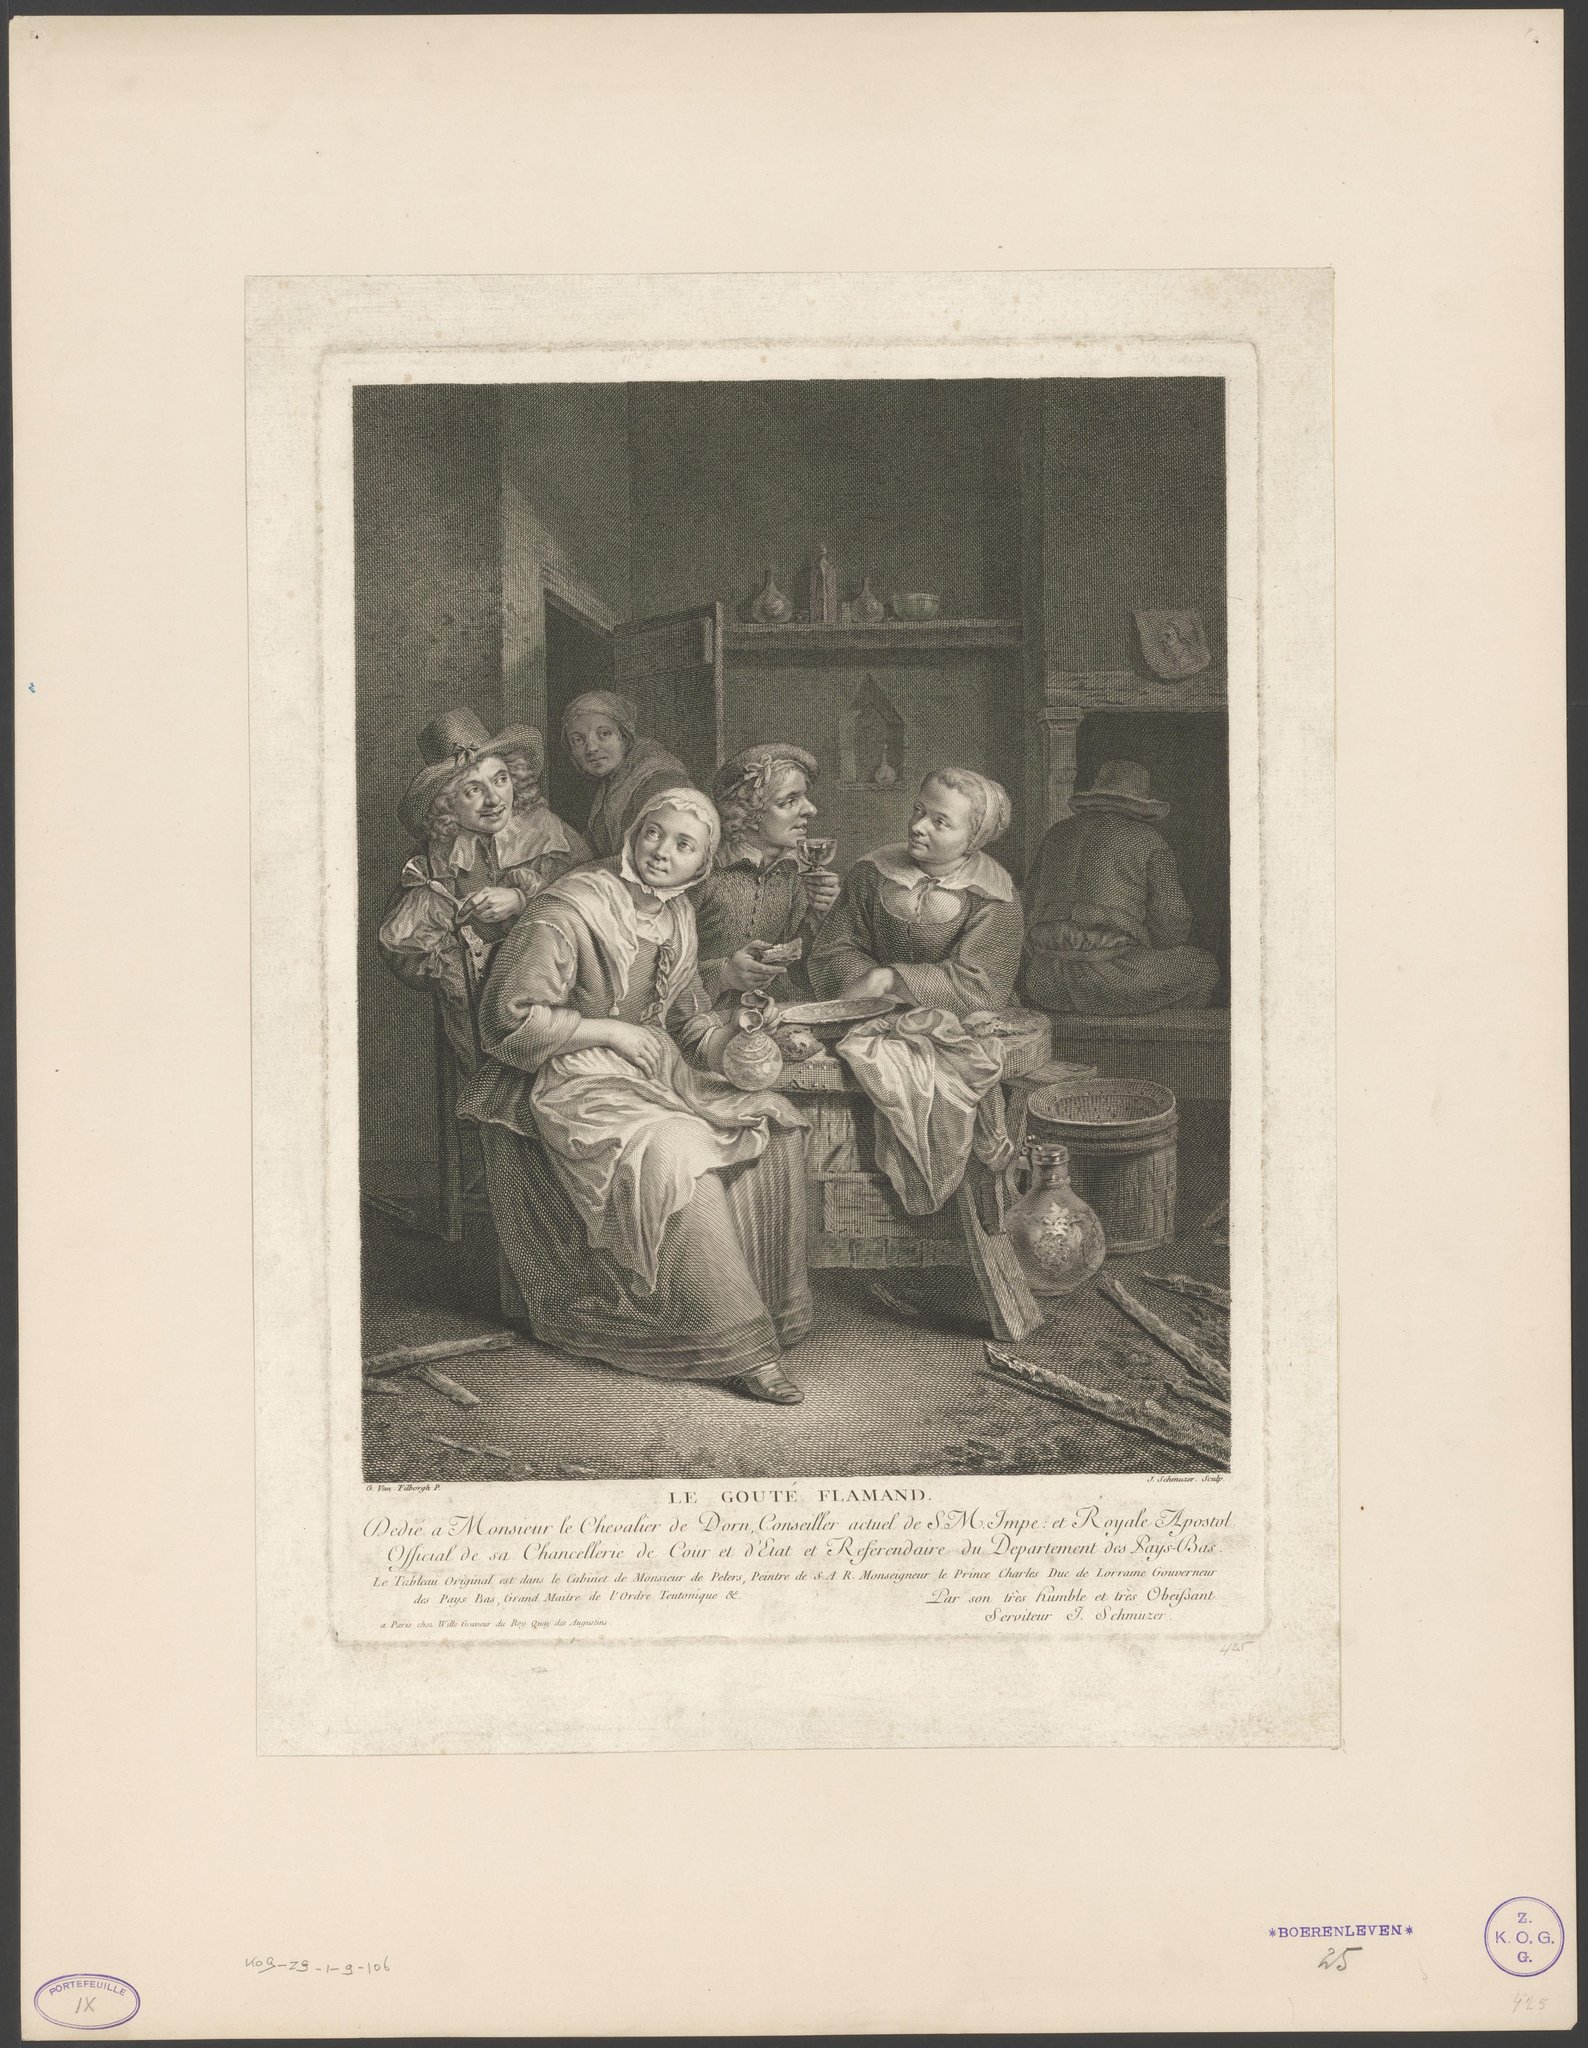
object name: print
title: Le gouté Flamand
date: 1743-1811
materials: paper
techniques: engraving, etching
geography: paris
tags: taste, tasting (one of the five senses), inn, coffee-house, public house, etc., wine ~ alcoholic drinks, drinking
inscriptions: collector's mark: Lugt 1641, stamp, stamp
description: In een kamer zitten twee koppels aan een tafel. Ze eten en drinken. Op de achtergrond verlaat de meid de kamer. Rechts zit een man bij de haard. Onderaan vier regels tekst. Onderwerpsrubrieken binnen de Atlas Zeden en Gewoonten: Handel, nijverheid en verkeer, Boerenleven.